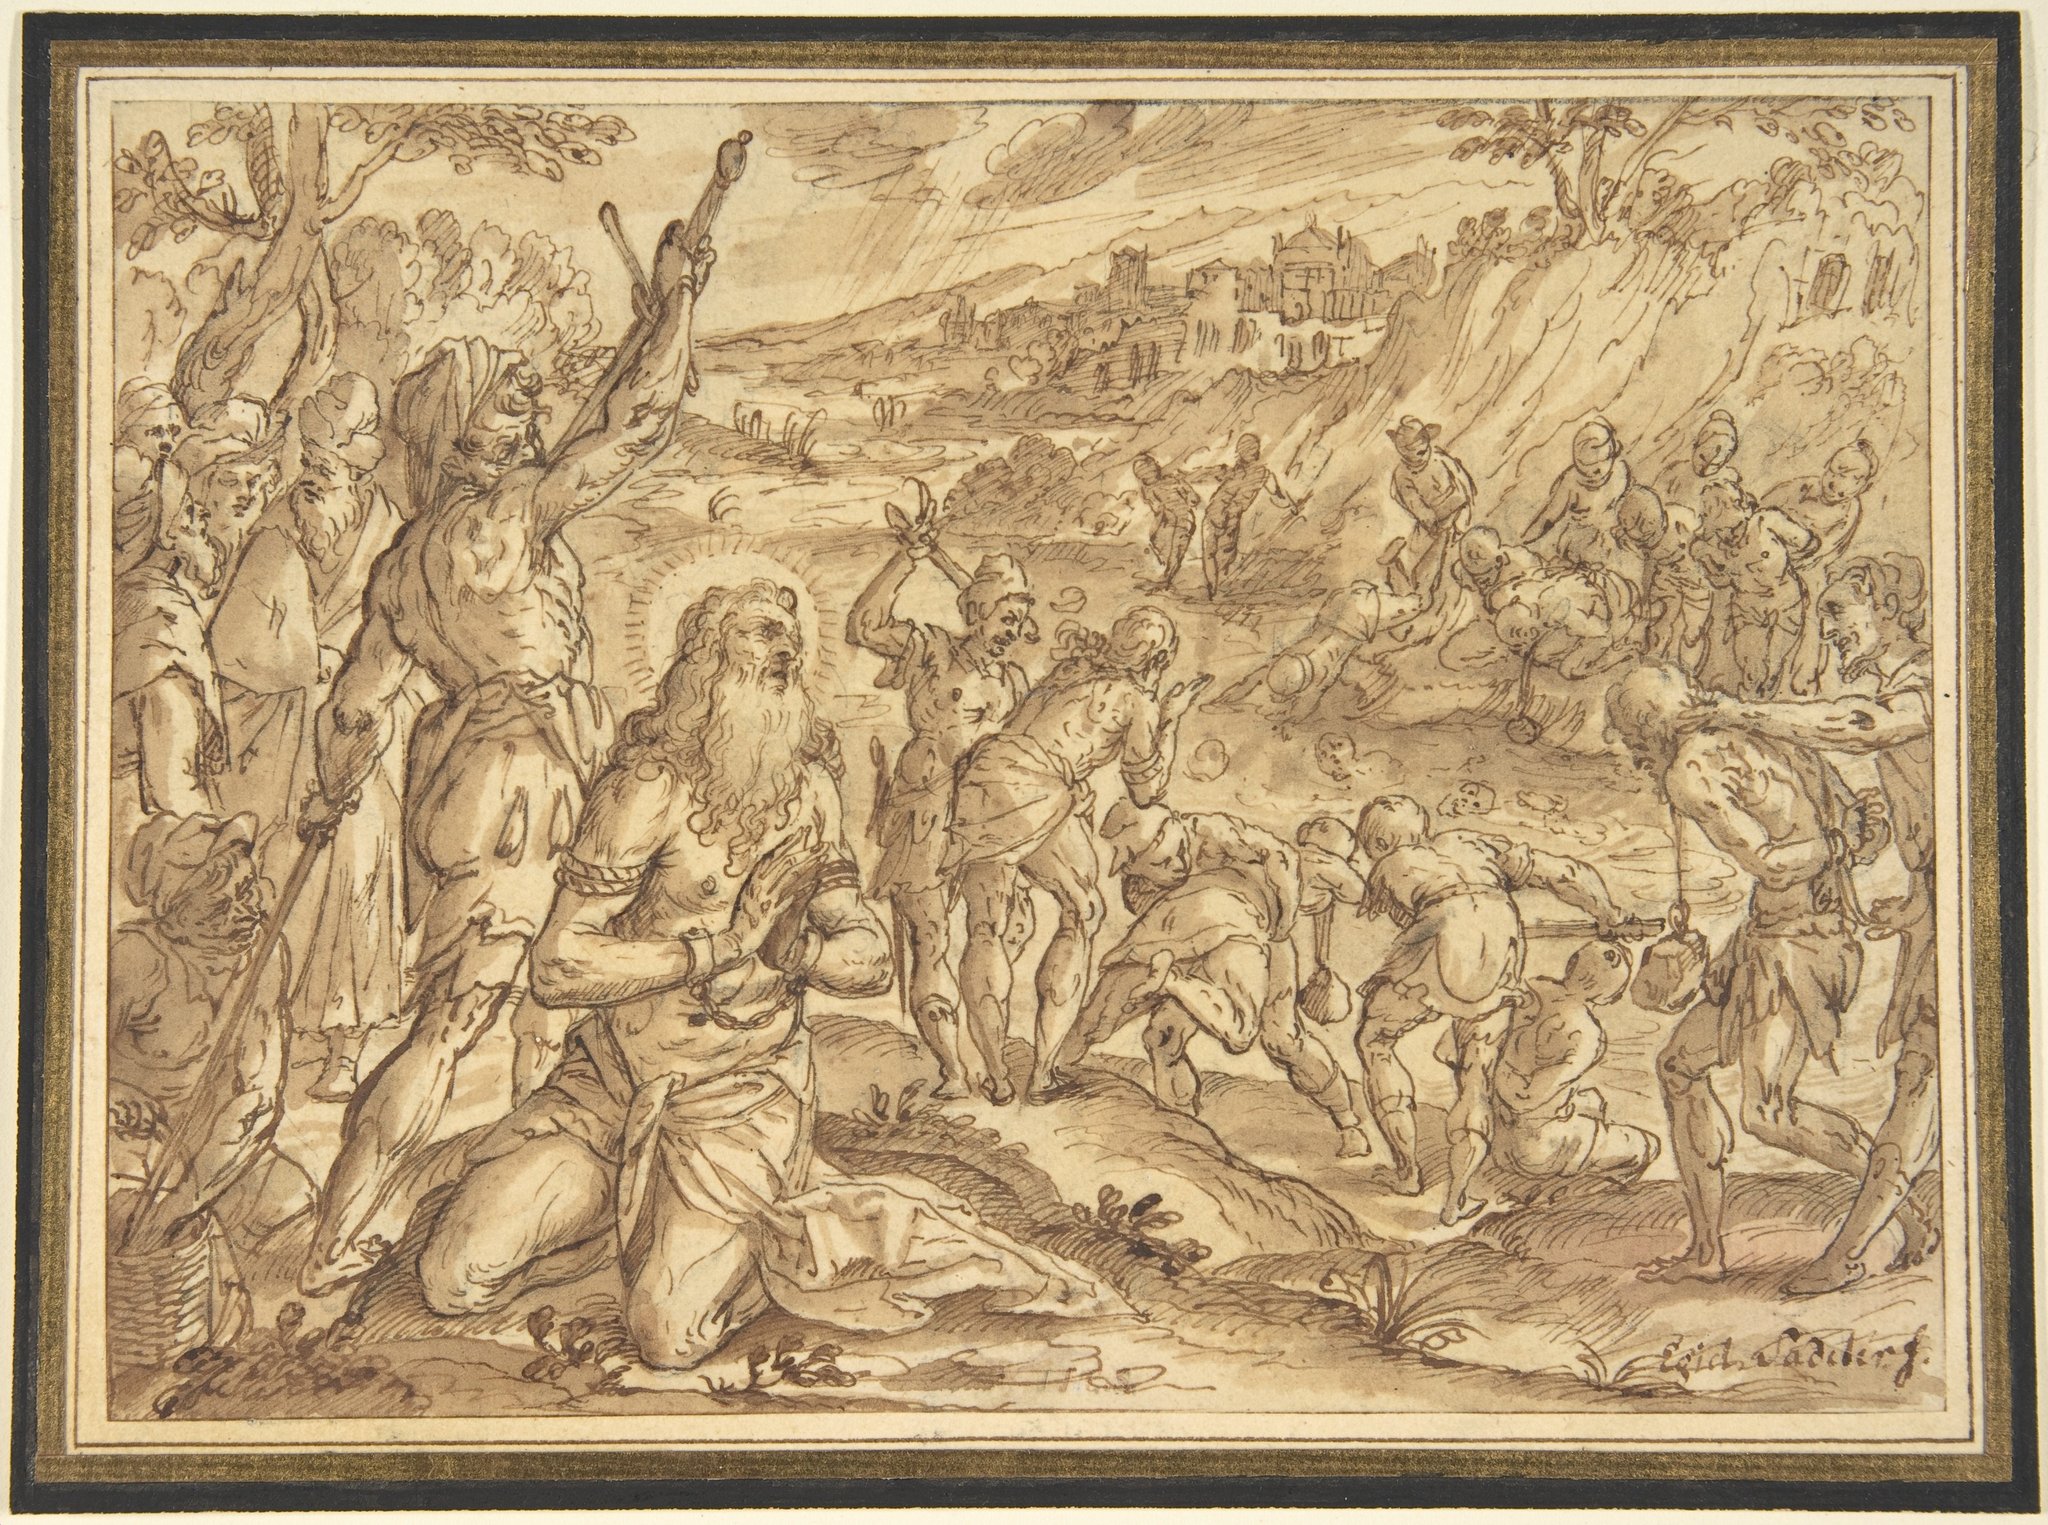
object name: drawing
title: Martyrdom of a Saint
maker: anonymous, netherlandish or german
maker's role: artist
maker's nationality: netherlandish or german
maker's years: 1400-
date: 1550-1650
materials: graphite, ink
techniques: brush, pen, wash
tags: human figures,suffering,saints